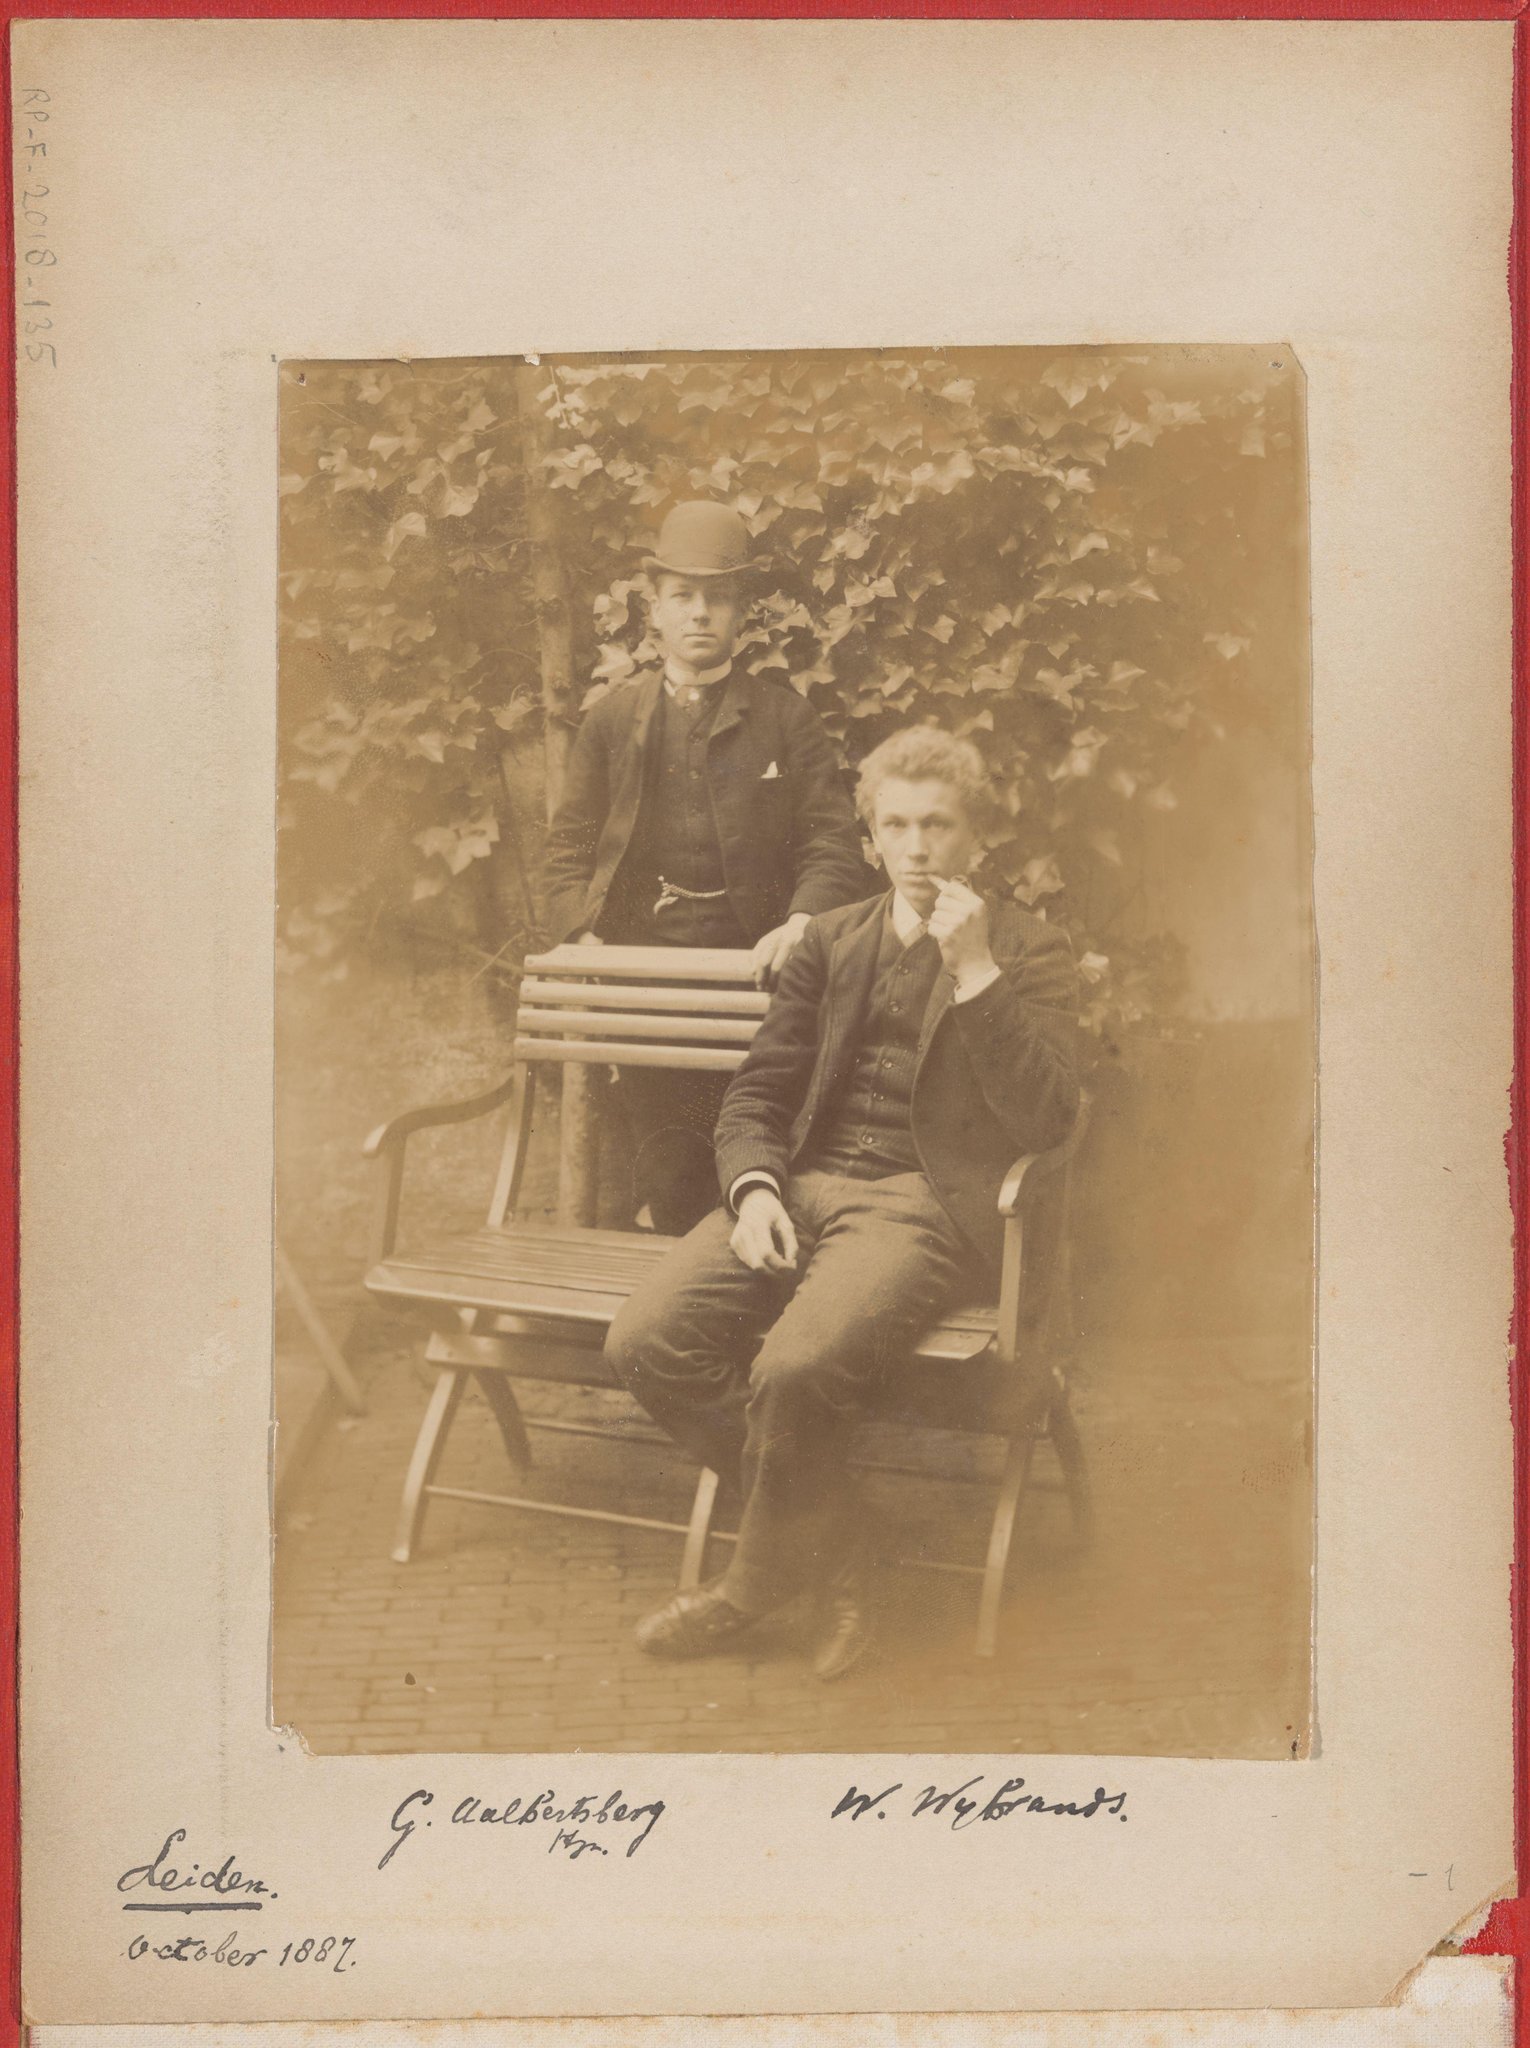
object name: photograph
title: Portret van Gerard Aalbersberg en W. Wybrants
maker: Anonymous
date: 1810-1887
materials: paper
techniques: gelatin silver print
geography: leiden